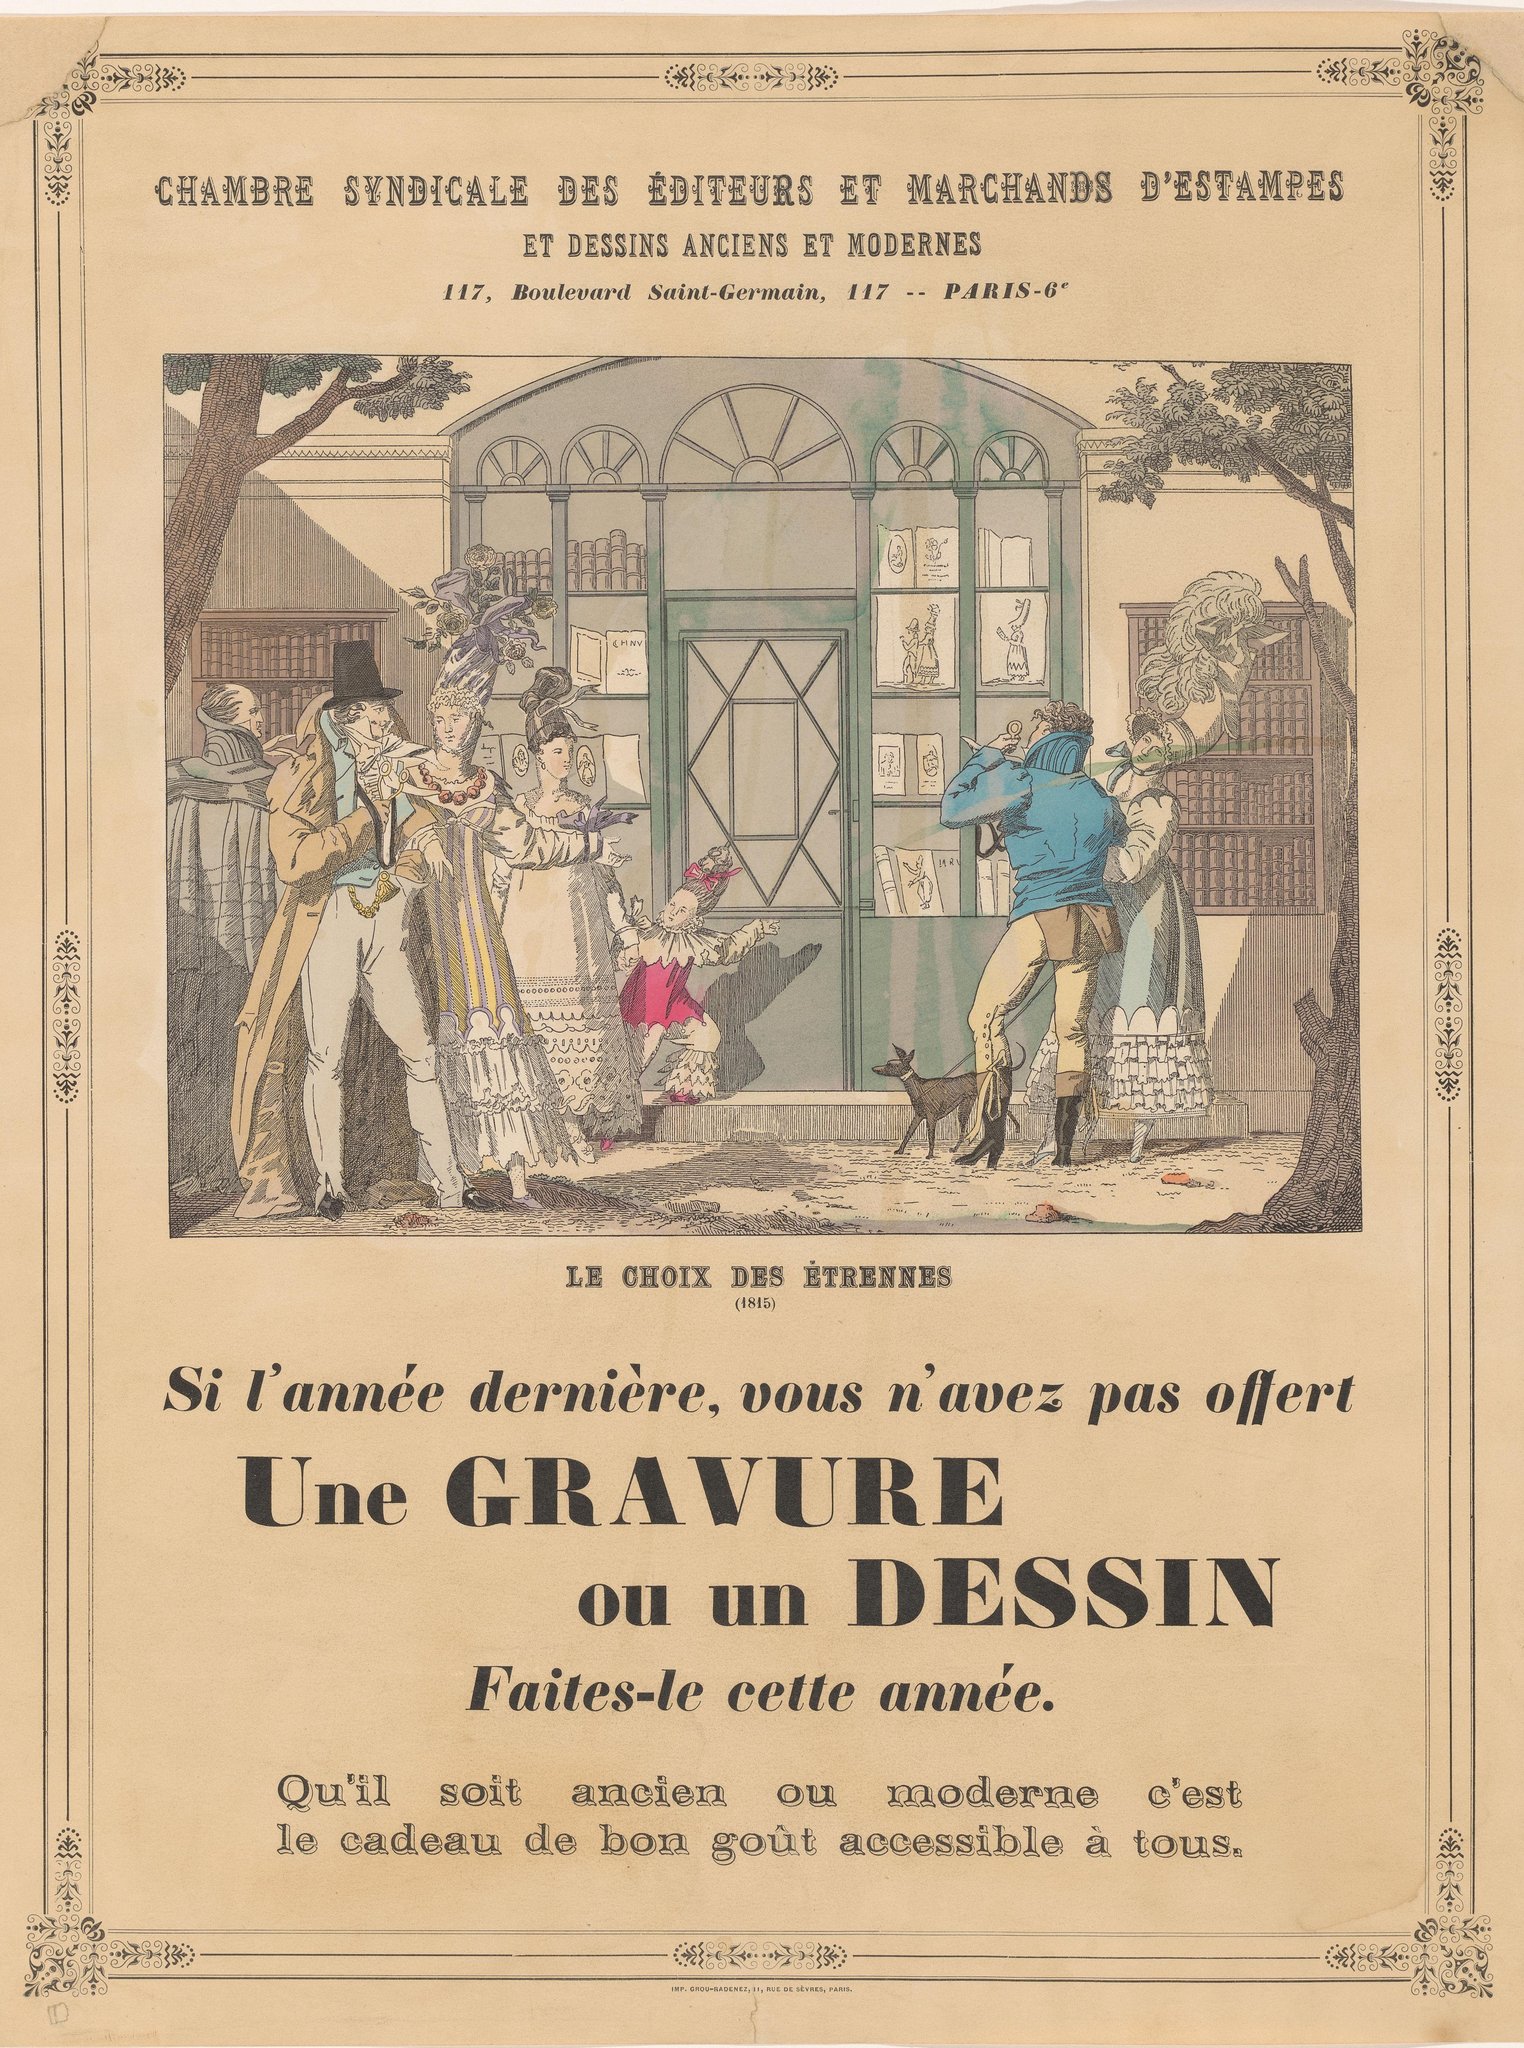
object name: poster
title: Affiche van de Chambre Syndicale des Éditeurs et Marchands d'Estampes et Dessins Anciens et Modernes te Parijs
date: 1919-1952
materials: paper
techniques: hand coloring, printing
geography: paris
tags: art dealer (+ graphic arts), shop-window, show-window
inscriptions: collector's mark: Lugt 2228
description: Modieus gekleed gezelschap voor de etalage van een prenthandel.